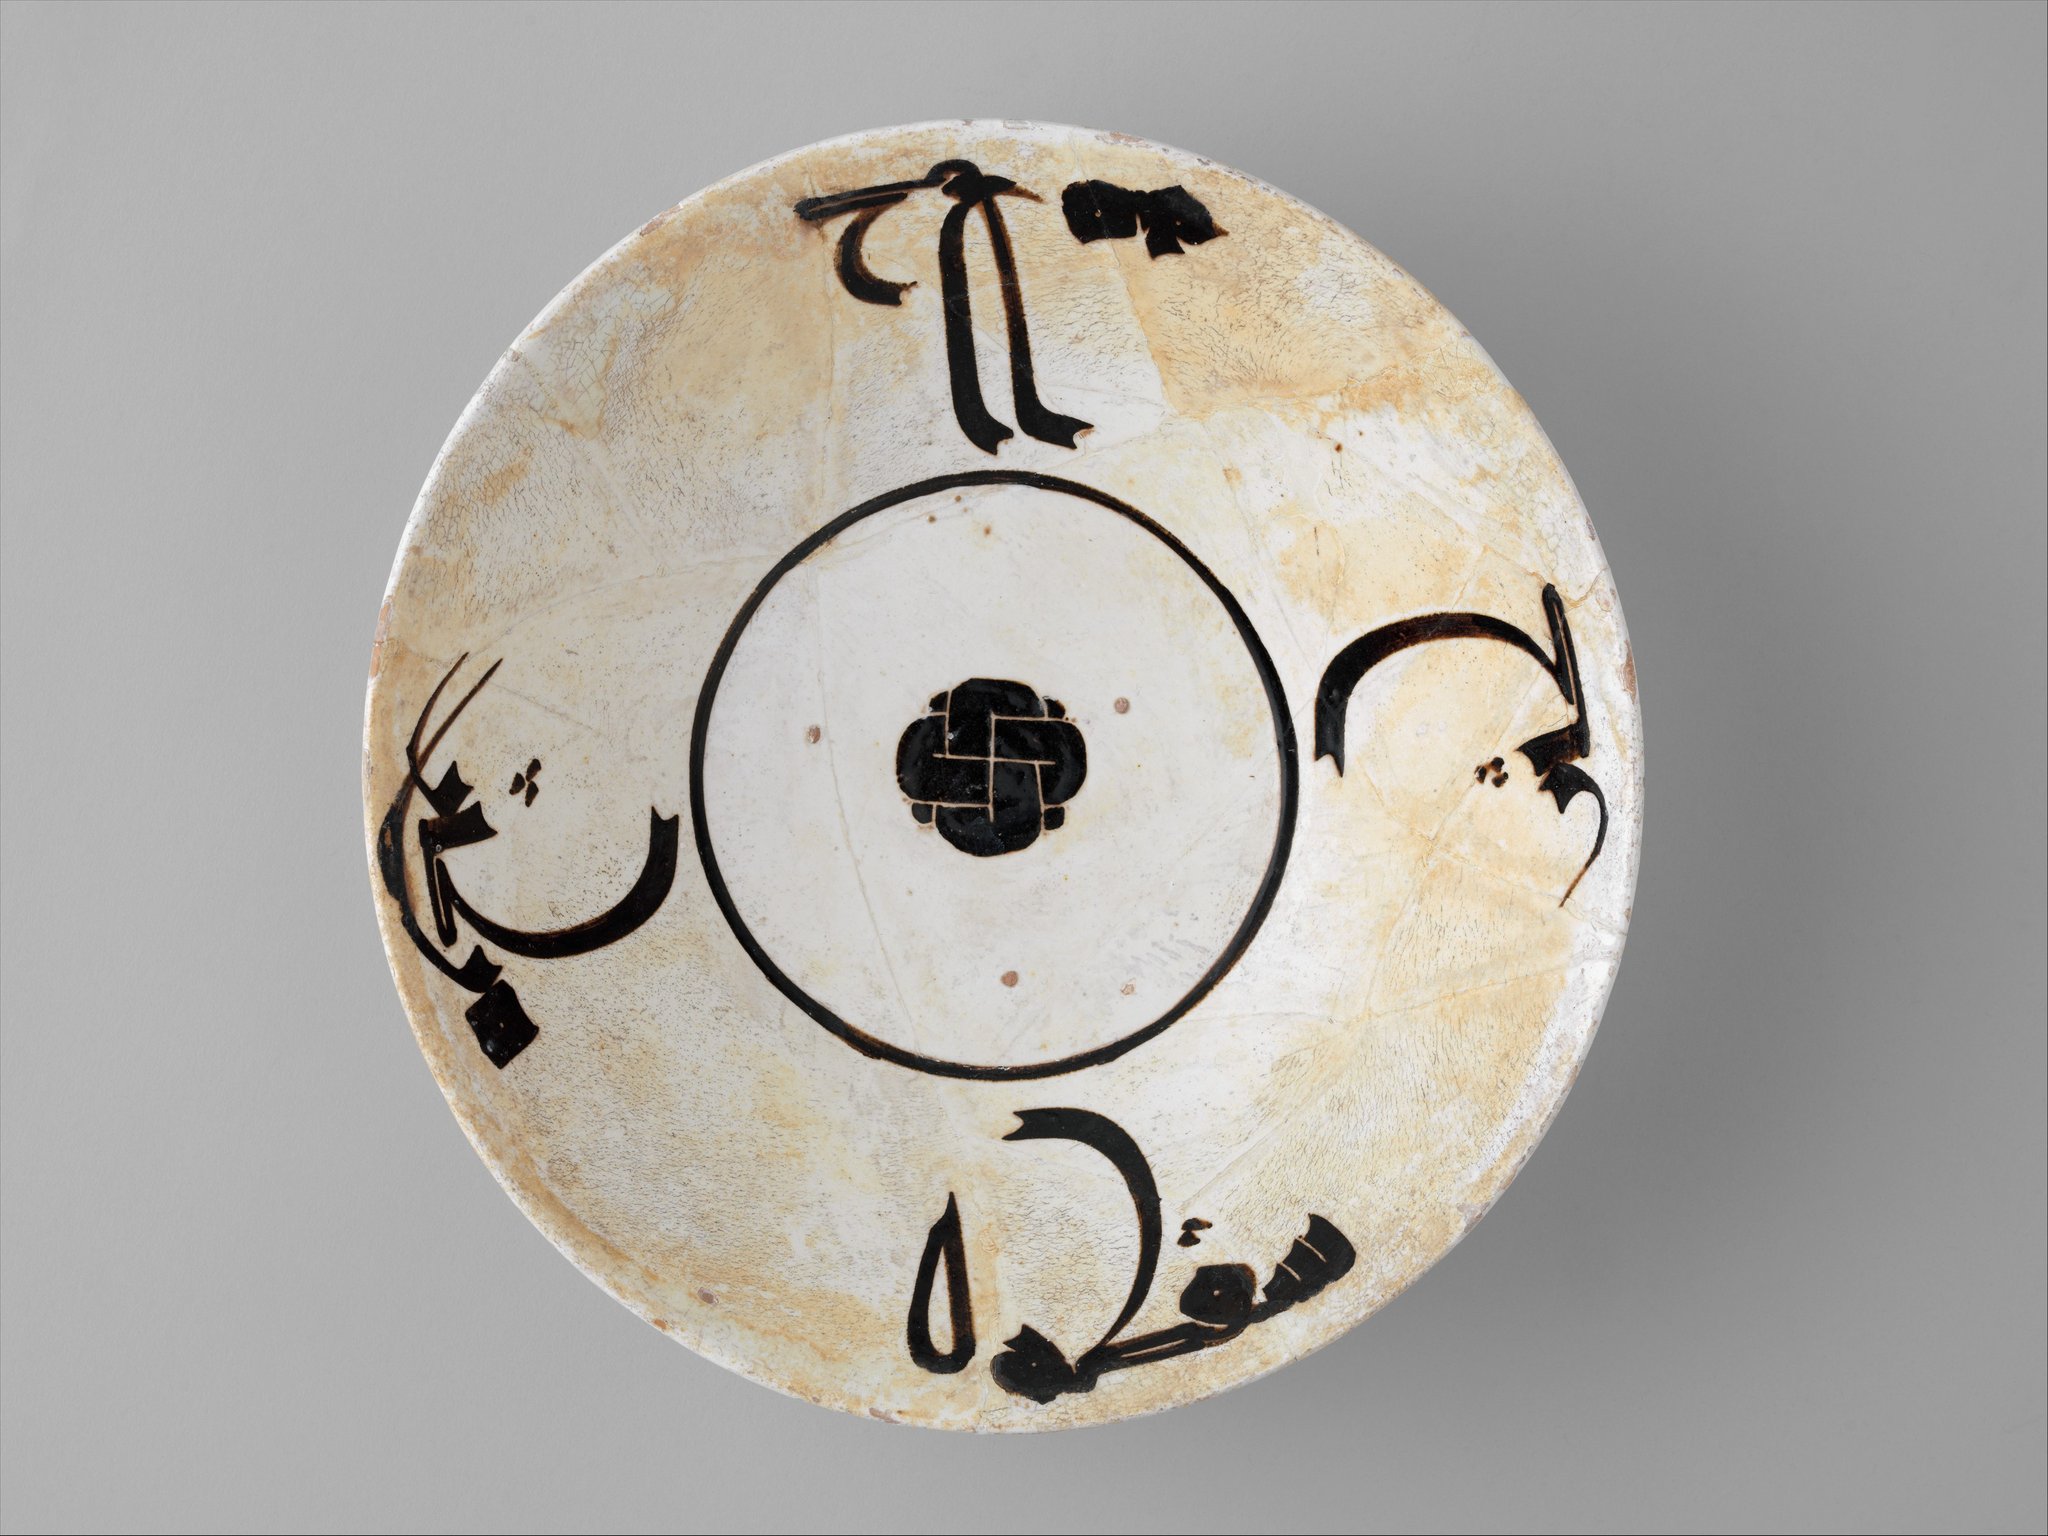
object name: bowl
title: Bowl with Inscription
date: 901-1000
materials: earthenware, glaze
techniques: incising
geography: uzbekistan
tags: arabic